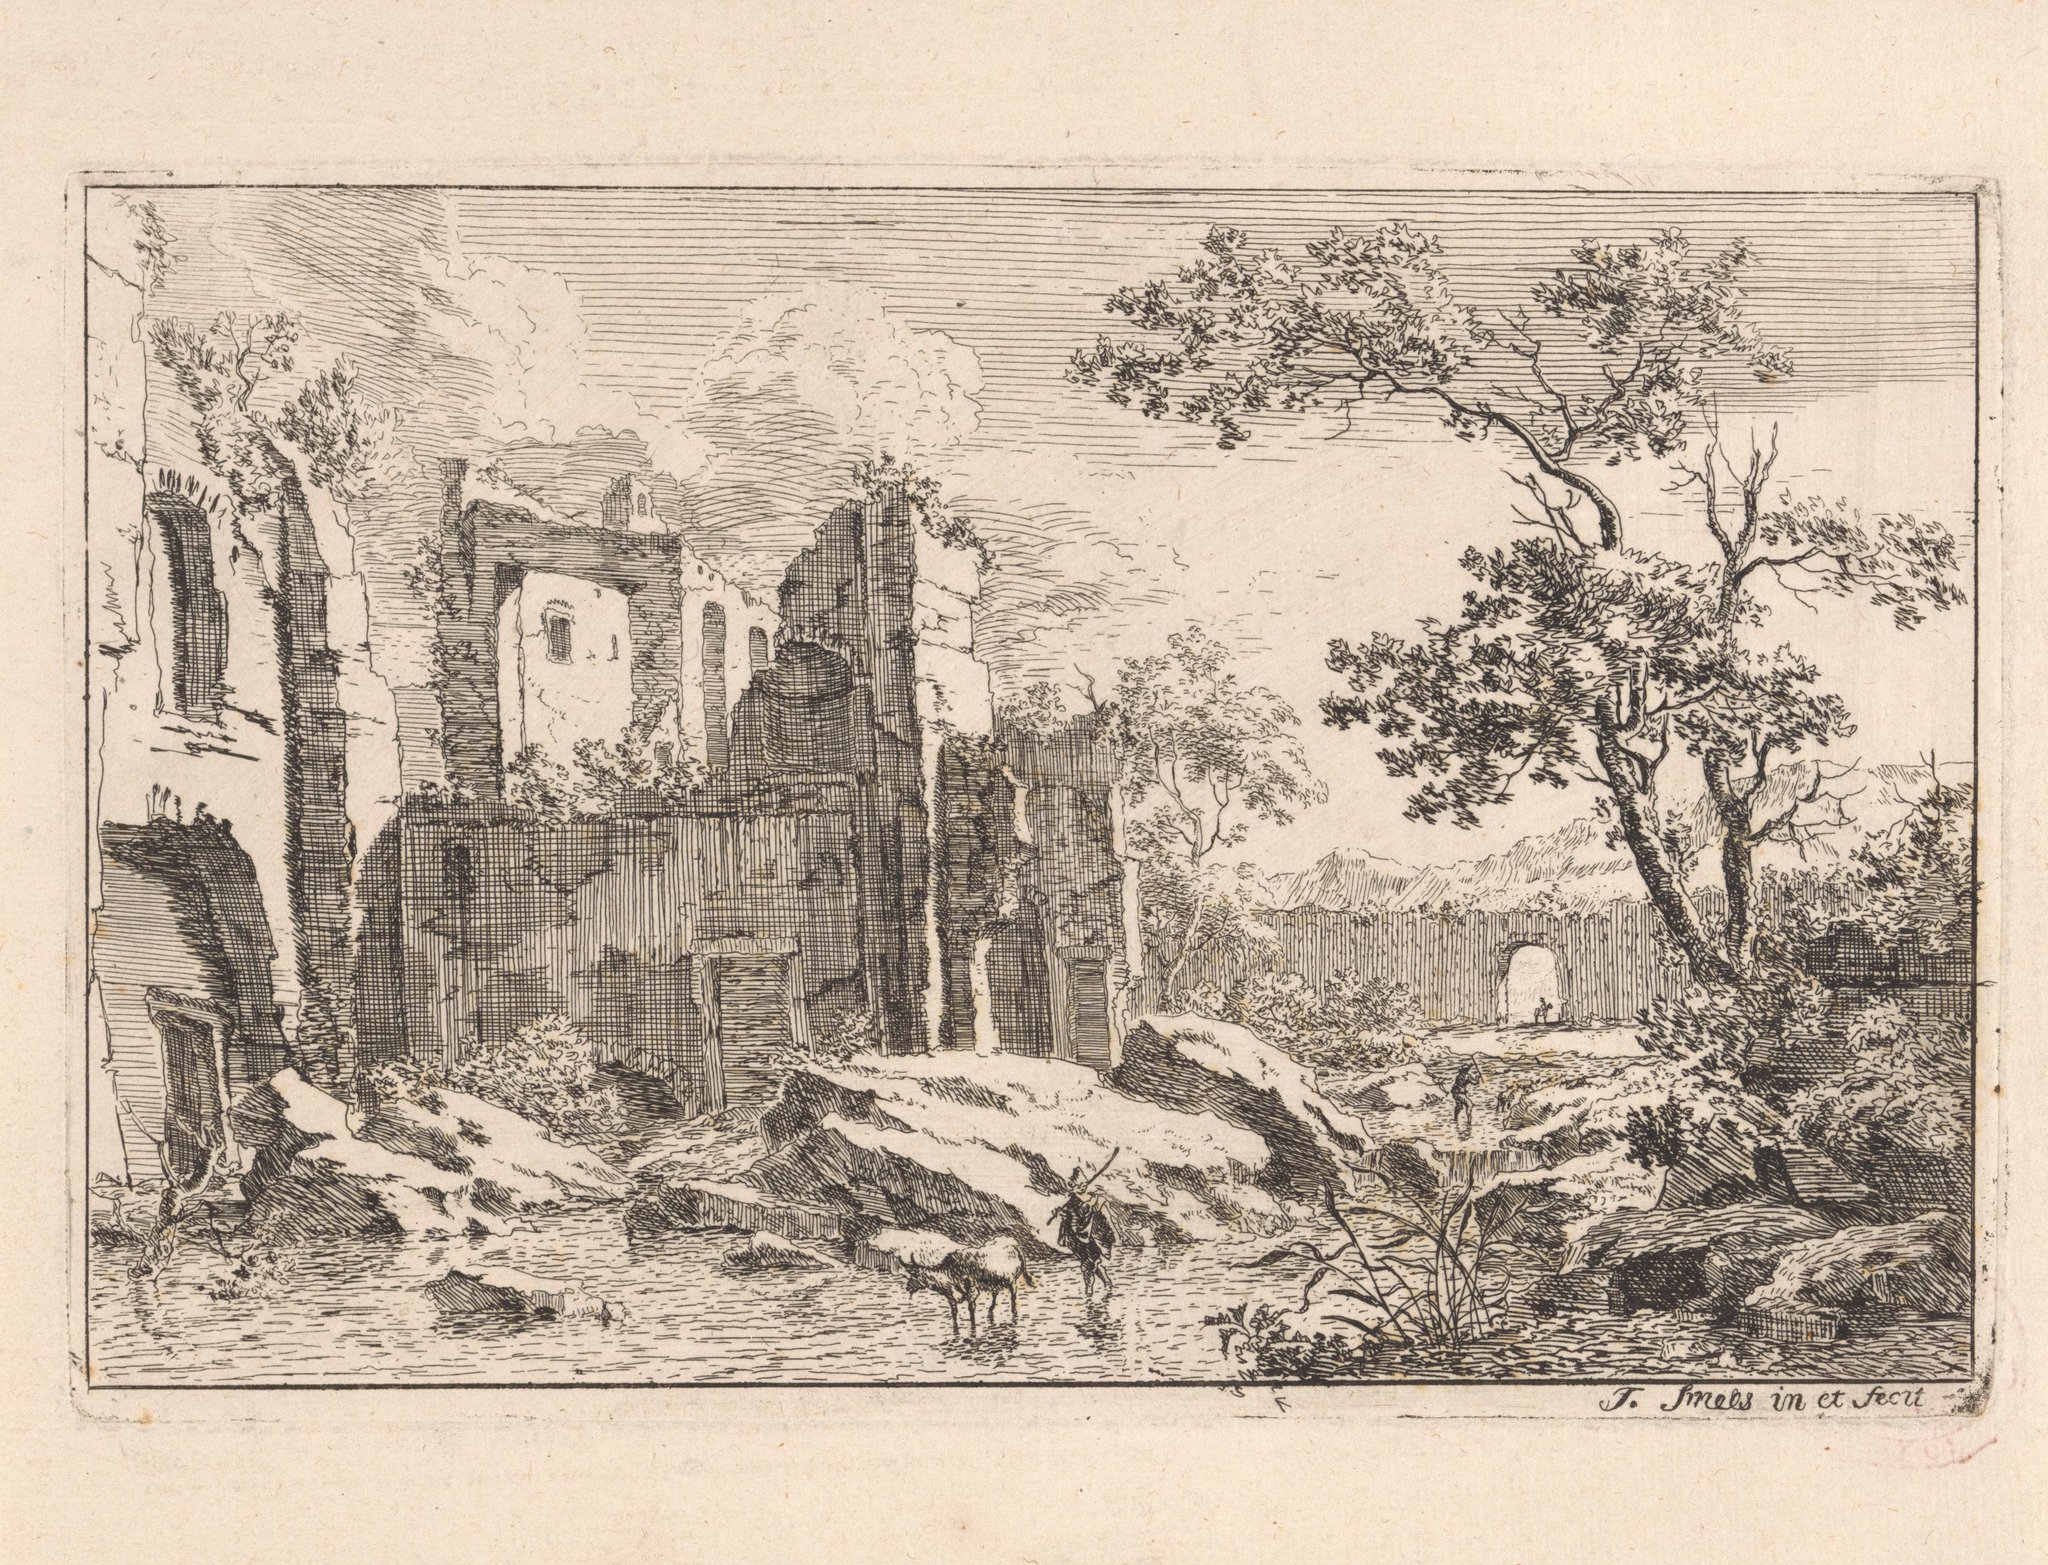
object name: print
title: Landschap met ruïne en herder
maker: jan smees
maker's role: draughtsman, print maker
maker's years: 1670-1729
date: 1705-1729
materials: paper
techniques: etching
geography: amsterdam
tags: cow, landscape with ruins - ii - ideal landscapes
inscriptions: collector's mark: Lugt 240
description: Landschap met een ruïne. Een herder waadt met een geit door het water aan de voet van het bouwwerk. Op de achtergrond een muur met een ronde toegangspoort, waarbij een ruiter staat.